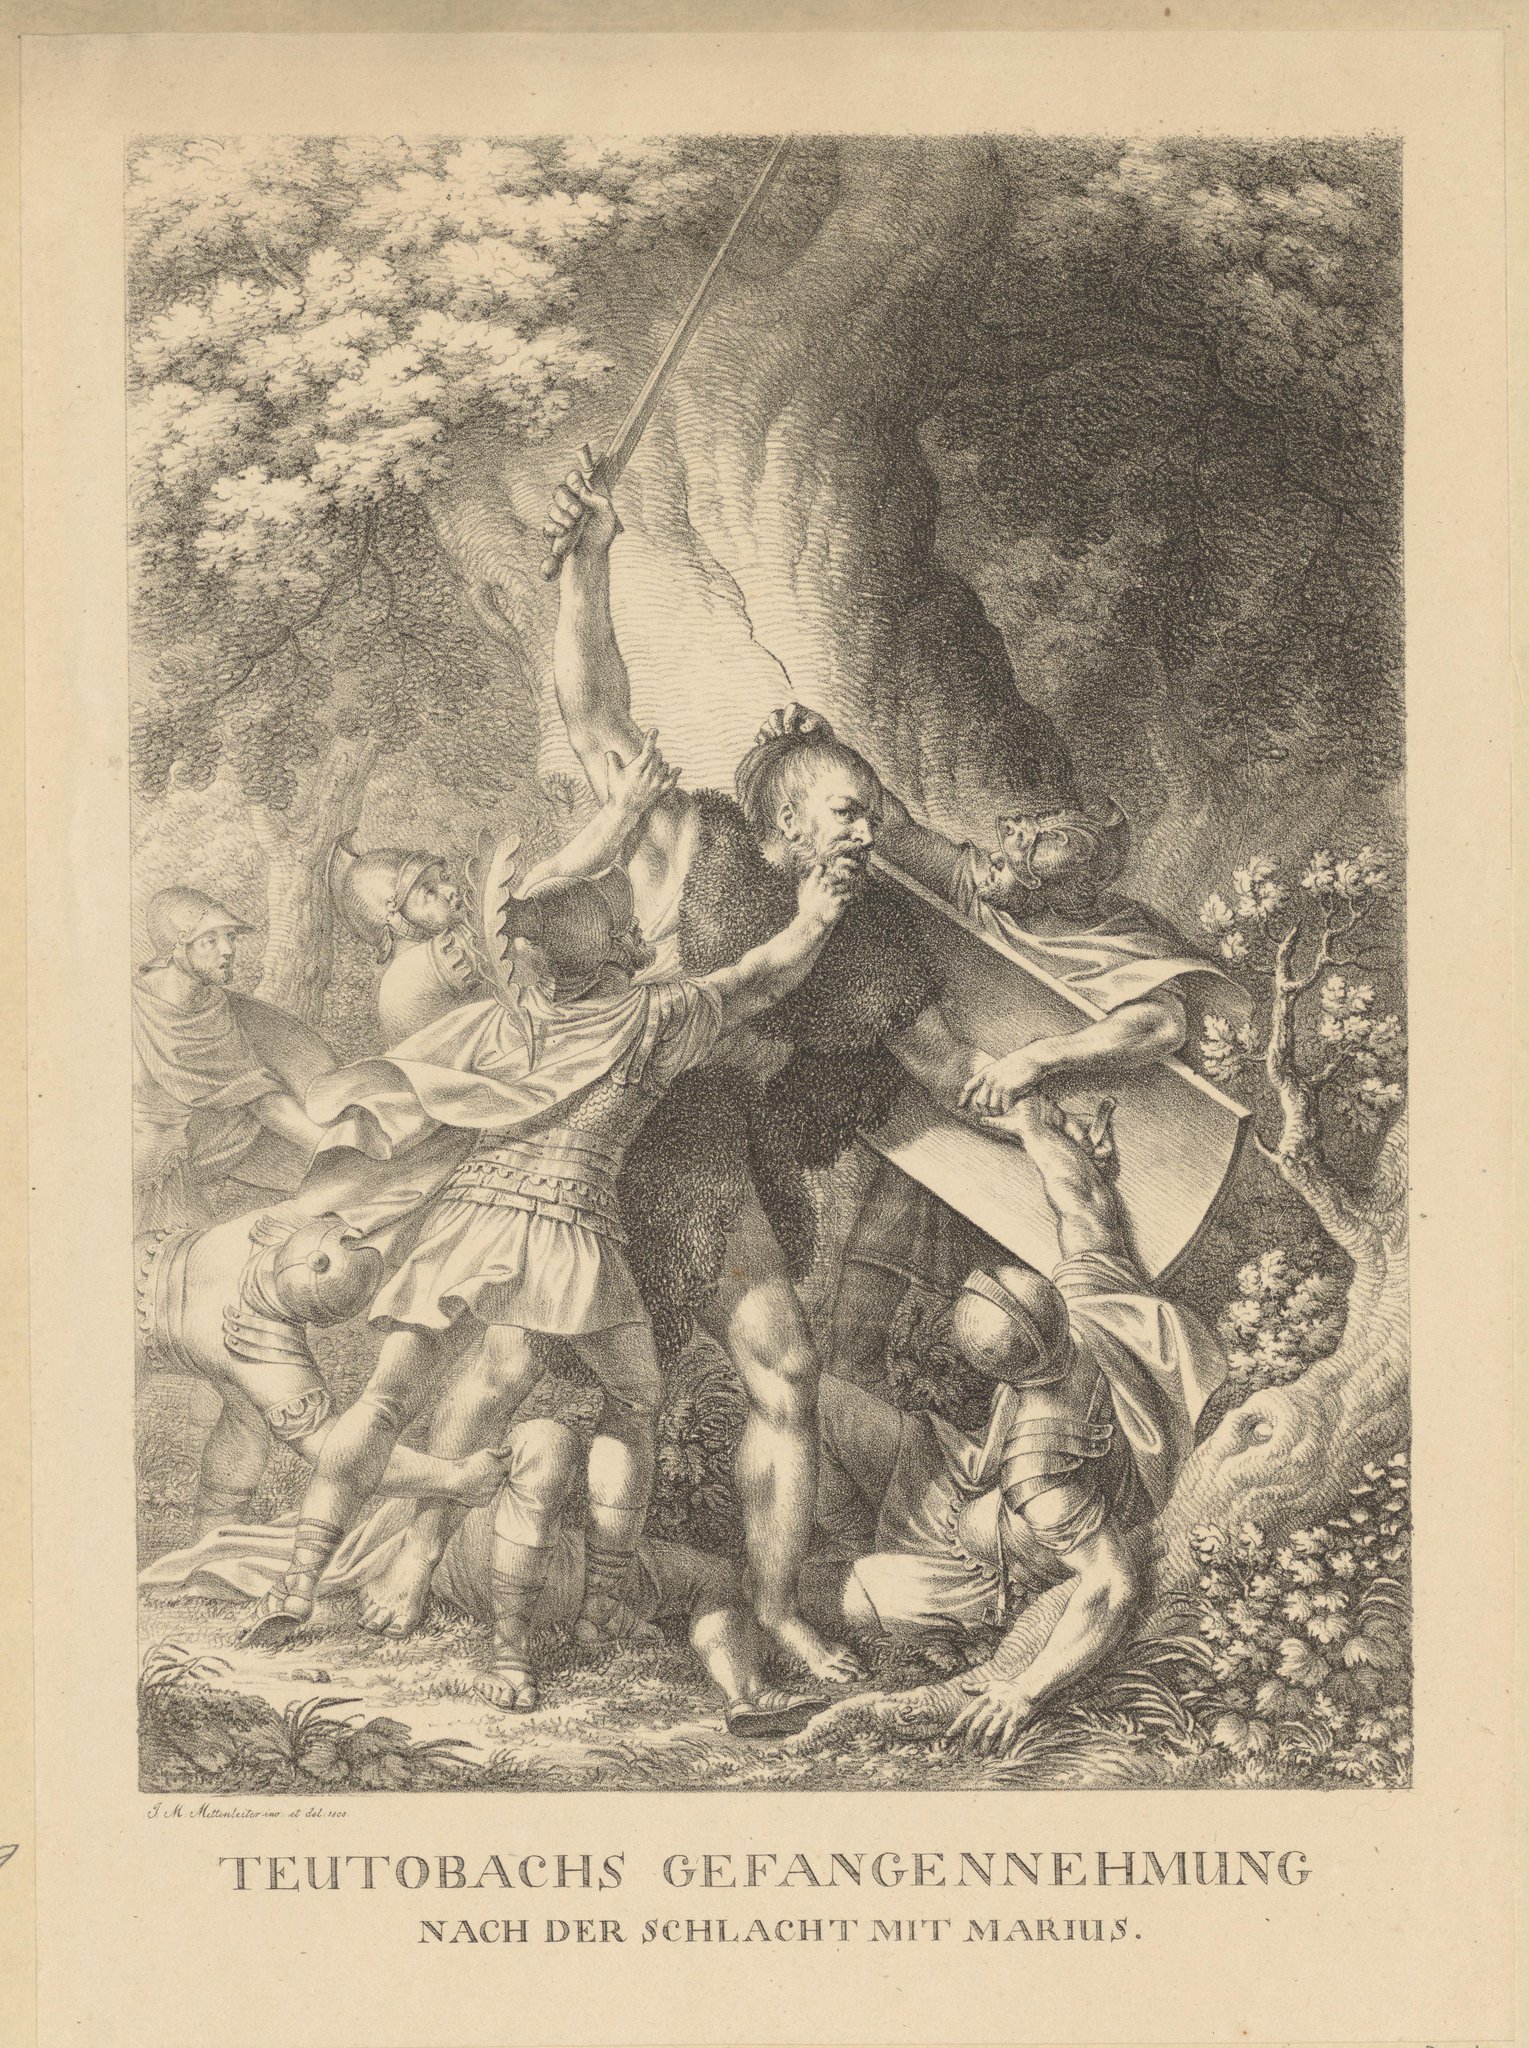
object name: print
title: Gevangenneming van Teutobach na de slag met Marius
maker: johann michael mettenleiter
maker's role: print maker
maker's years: 1765-1853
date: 1808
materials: paper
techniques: lithograph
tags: warfare; military affairs, prisoner of war (after the battle)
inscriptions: collector's mark: Lugt 2228